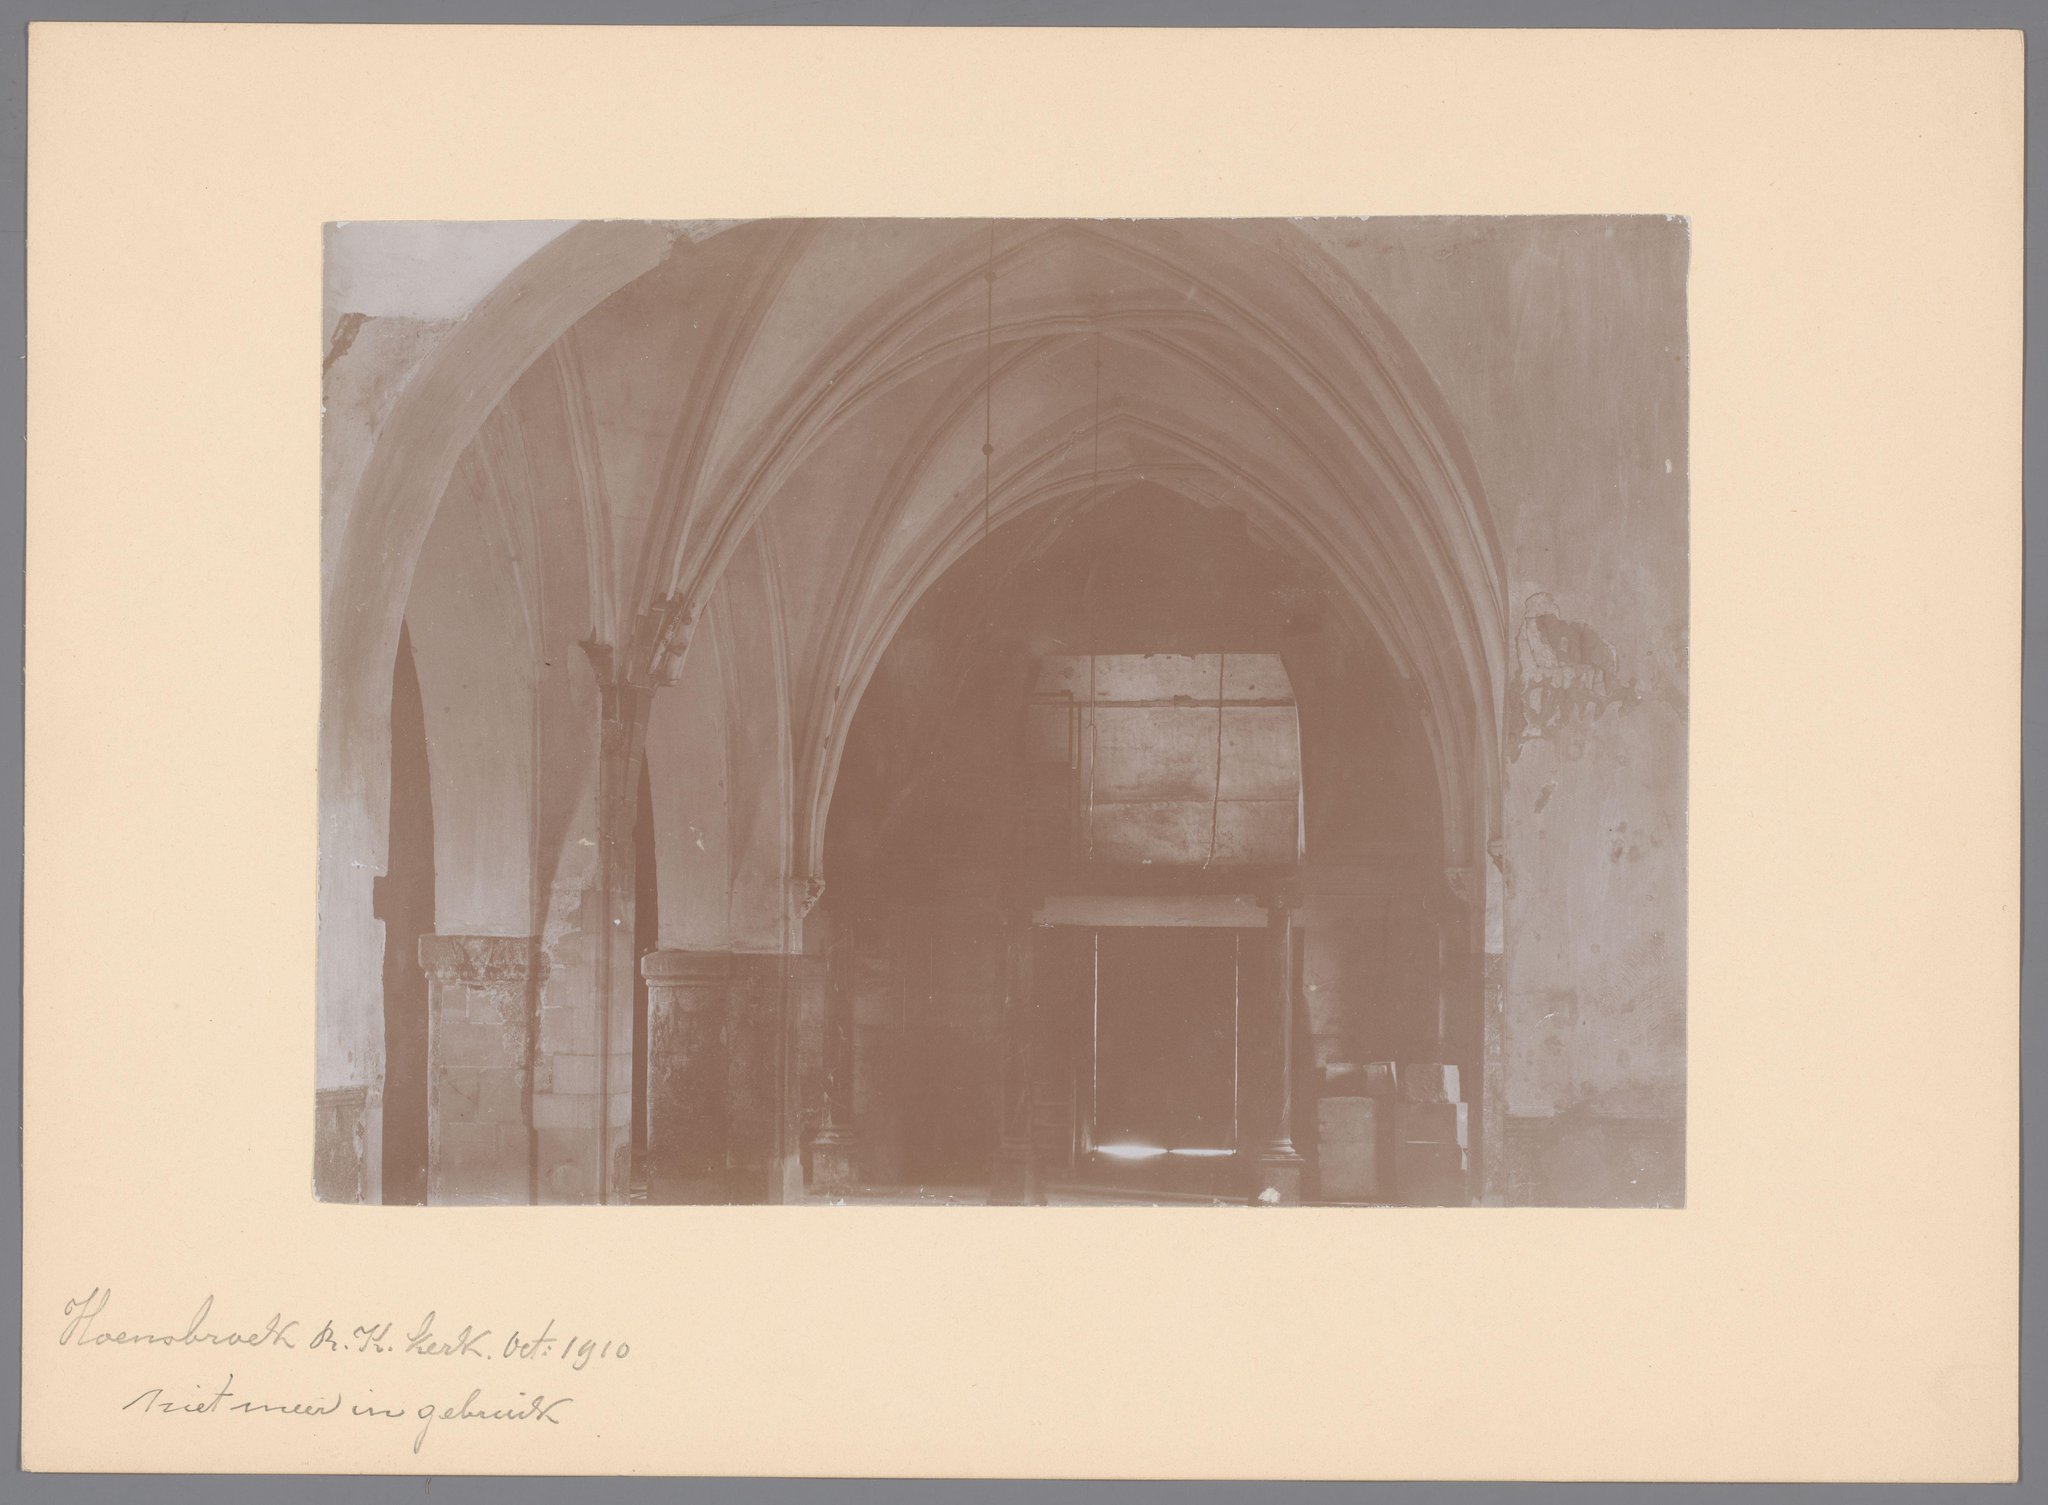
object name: photograph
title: Interieur van de Sint-Janskerk te Hoensbroek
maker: anoniem (monumentenzorg)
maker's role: fotograaf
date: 1910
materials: cardboard, photographic support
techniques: collodion silver print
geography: hoensbroek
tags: interior of church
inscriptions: annotation: ‘Hoensbroek R.K. Kerk oct: 1910/ niet meer in gebruik’